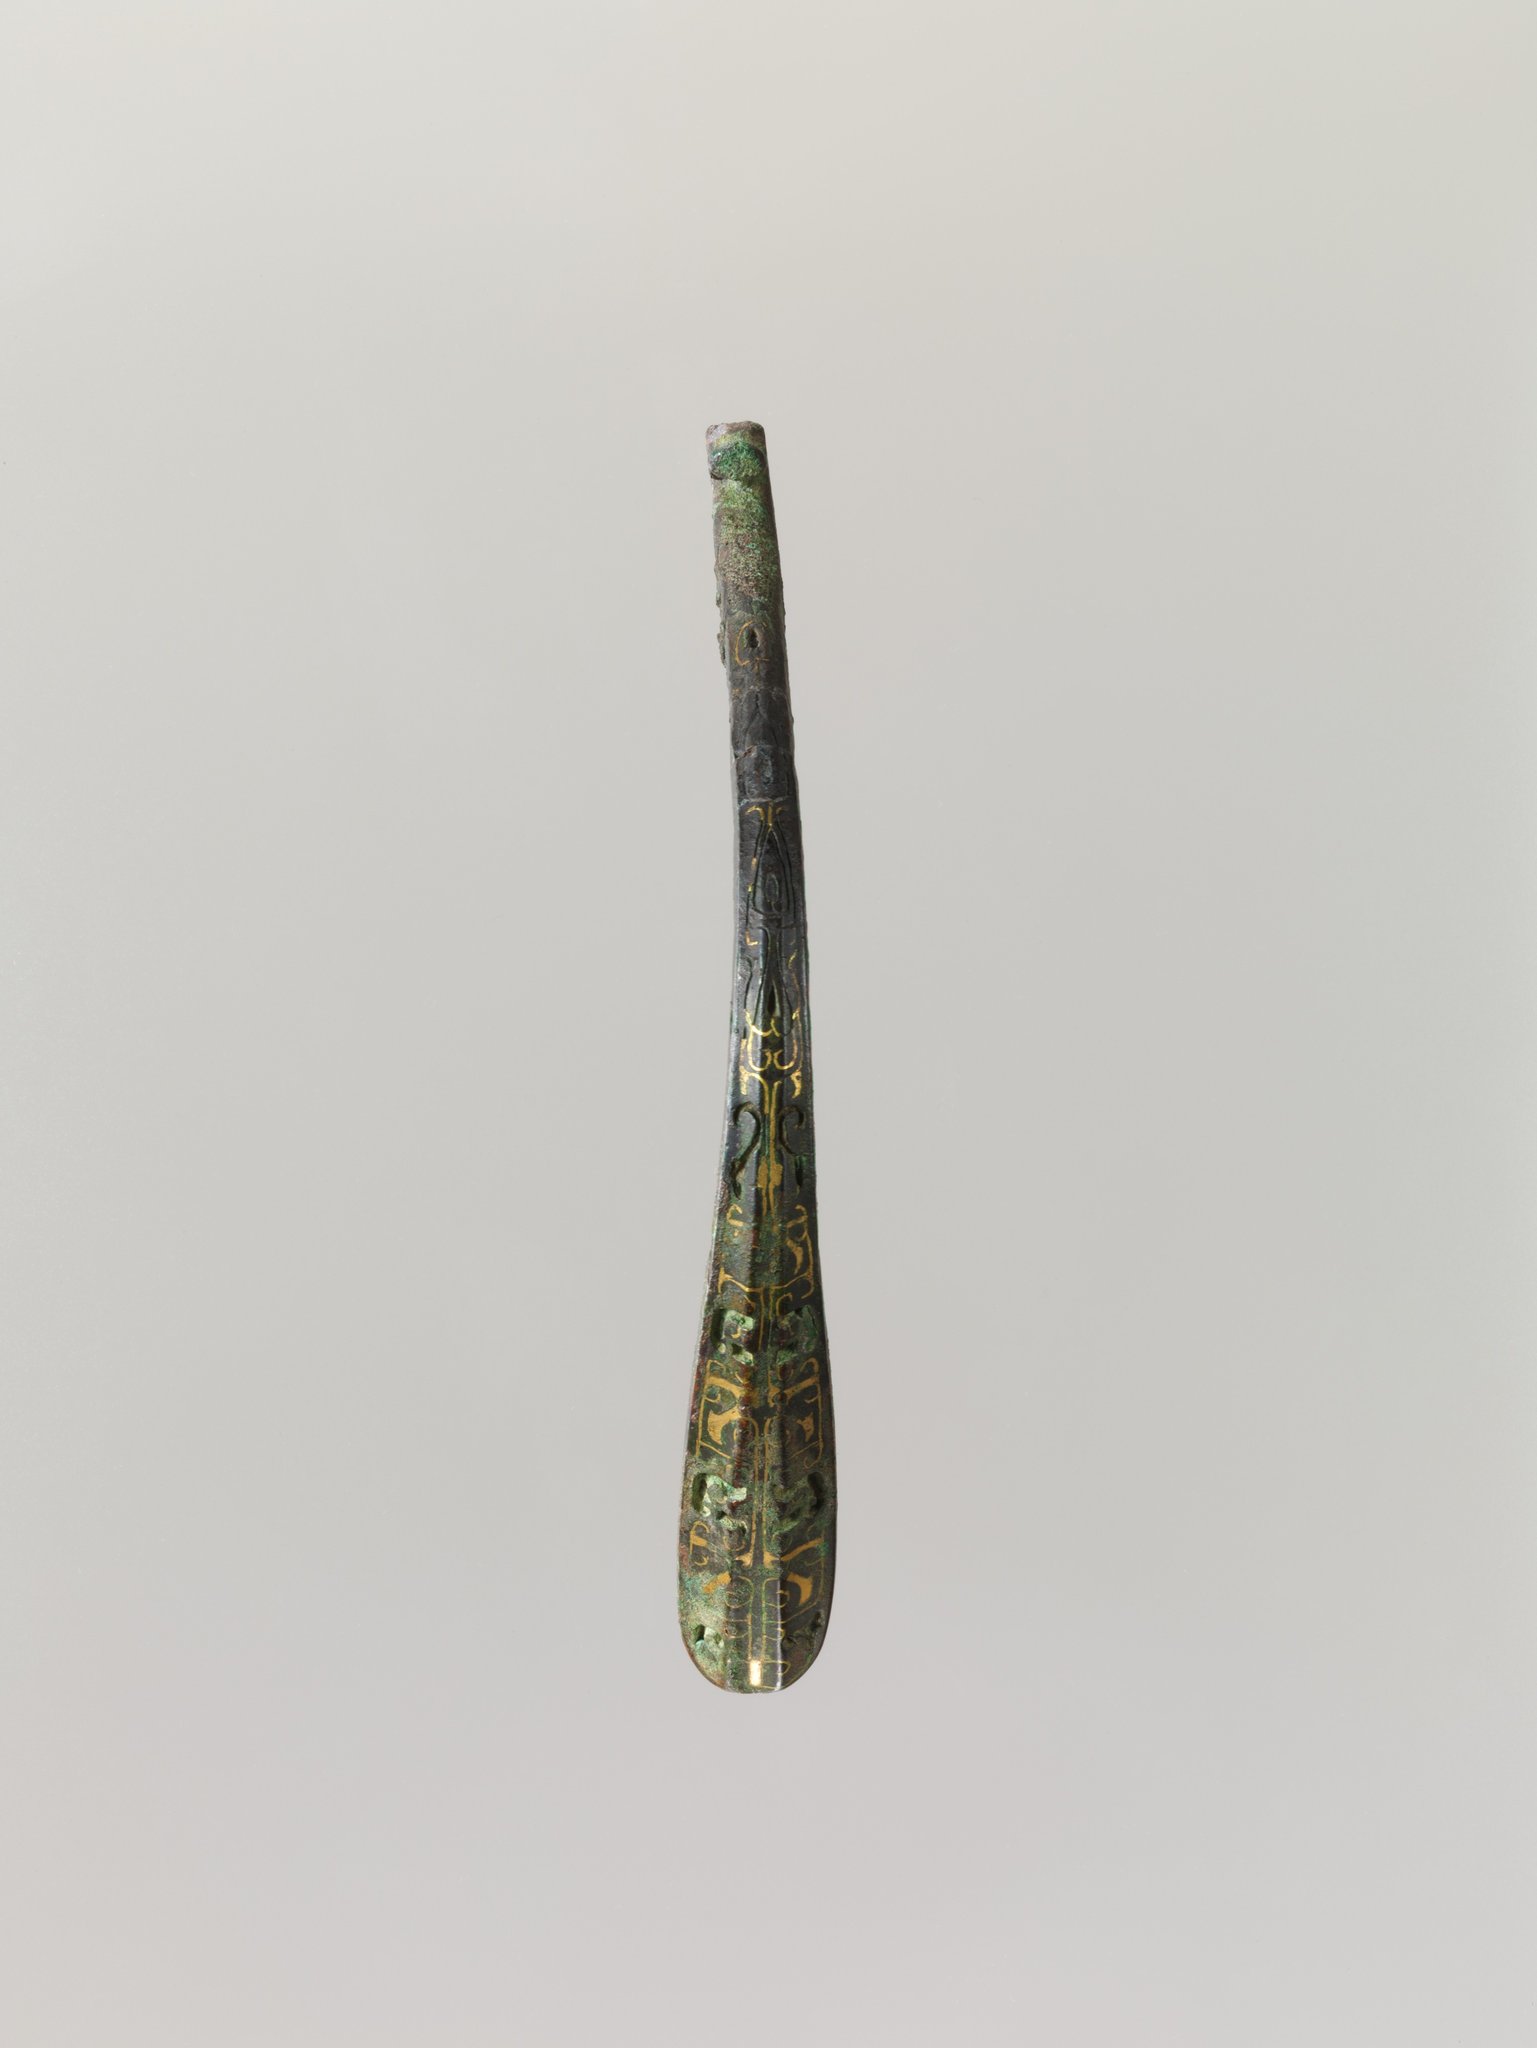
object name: buckle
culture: chinese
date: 206 BCE-220 CE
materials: bronze